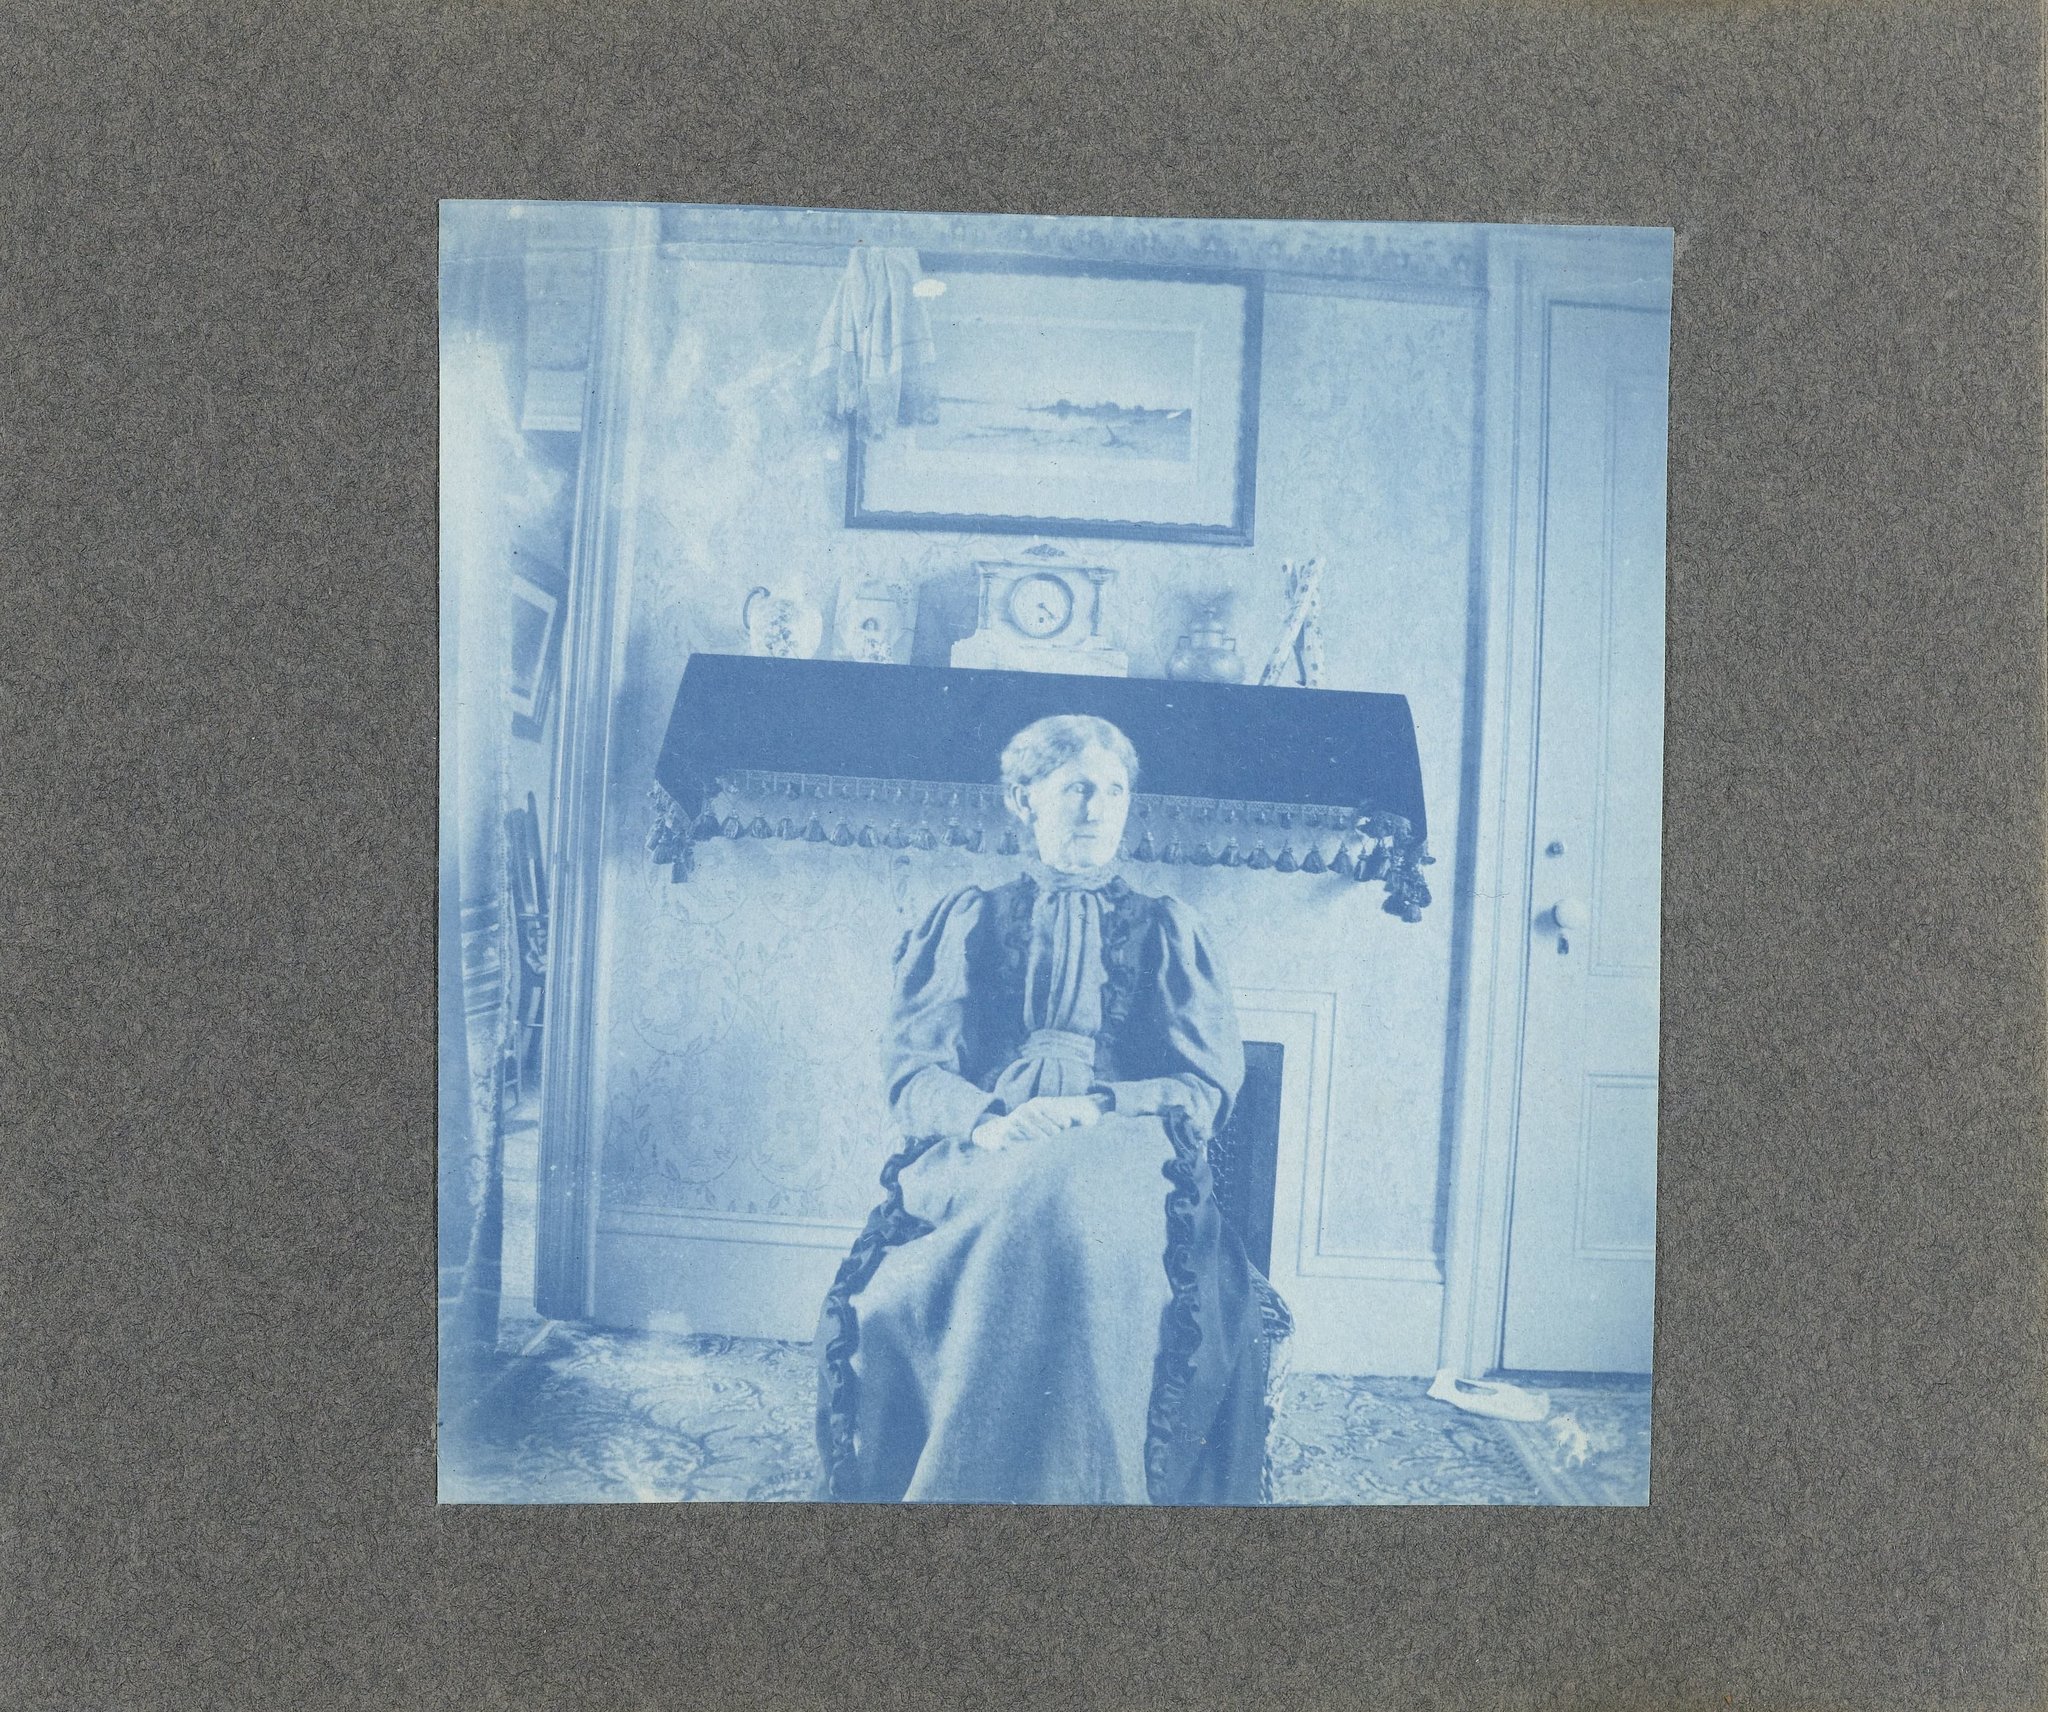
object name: photograph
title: Vrouw zittend in een interieur, Verenigde Staten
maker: Anonymous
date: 1900-1920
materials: paper, photographic support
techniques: cyanotype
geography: united states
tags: adult woman, historical persons, interior of the house, united states of america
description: Onderdeel van Fotoalbum met 53 cyanotypieën van kinderen, paarden, huizen, boten en strandtaferelen in de Verenigde Staten.